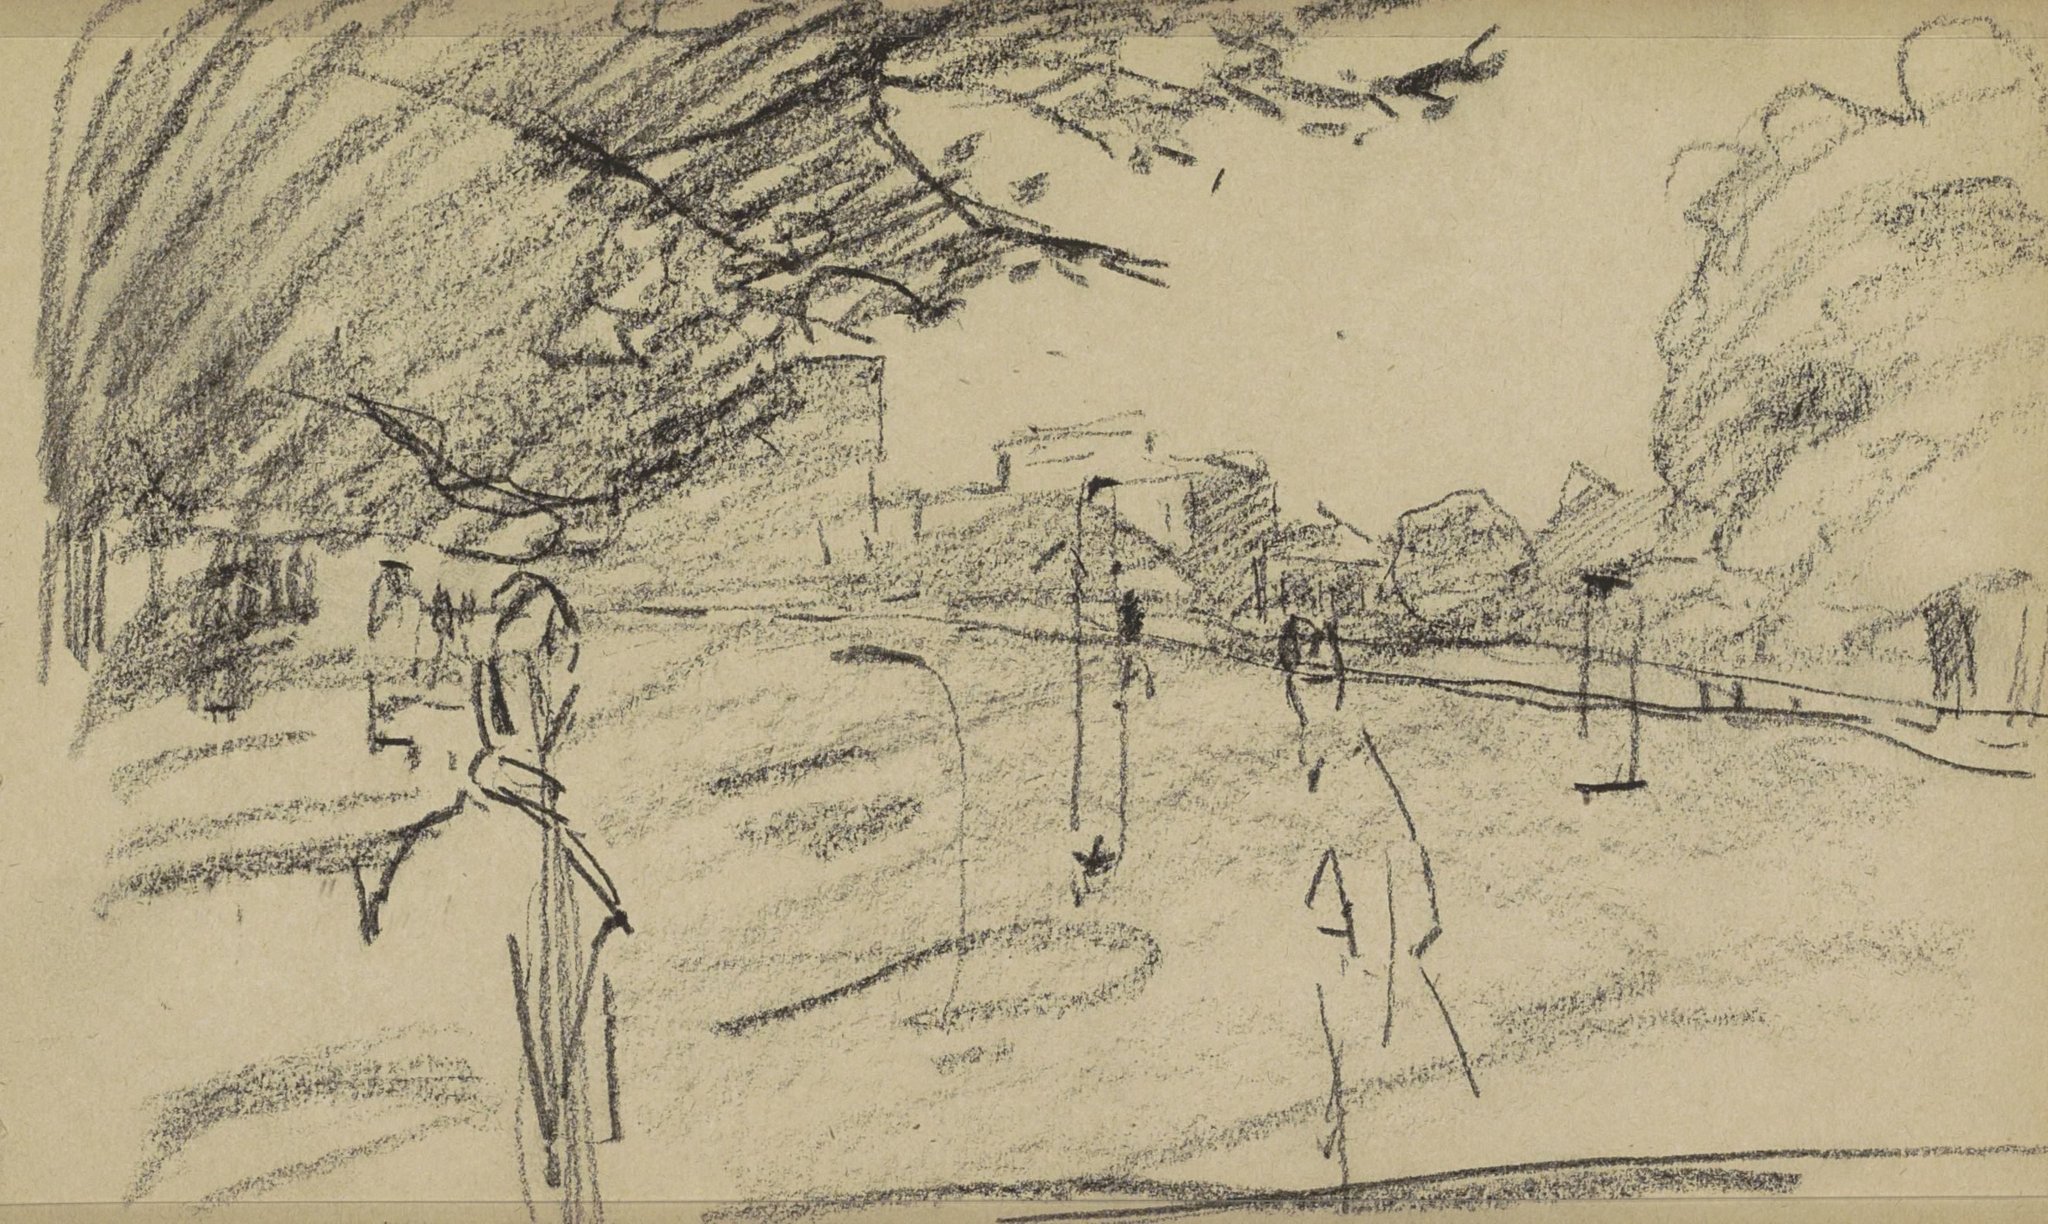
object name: sketchbook leaf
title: Gezicht op een park met bebouwing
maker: willem witsen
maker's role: draughtsman, painter, print maker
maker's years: 1860-1923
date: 1888-1891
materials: chalk, paper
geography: london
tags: park, civic architecture; edifices; dwellings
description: Mogelijk Apsley House aan de rand van Hyde Park te Londen. Pagina 39 uit een schetsboek met 27 bladen.